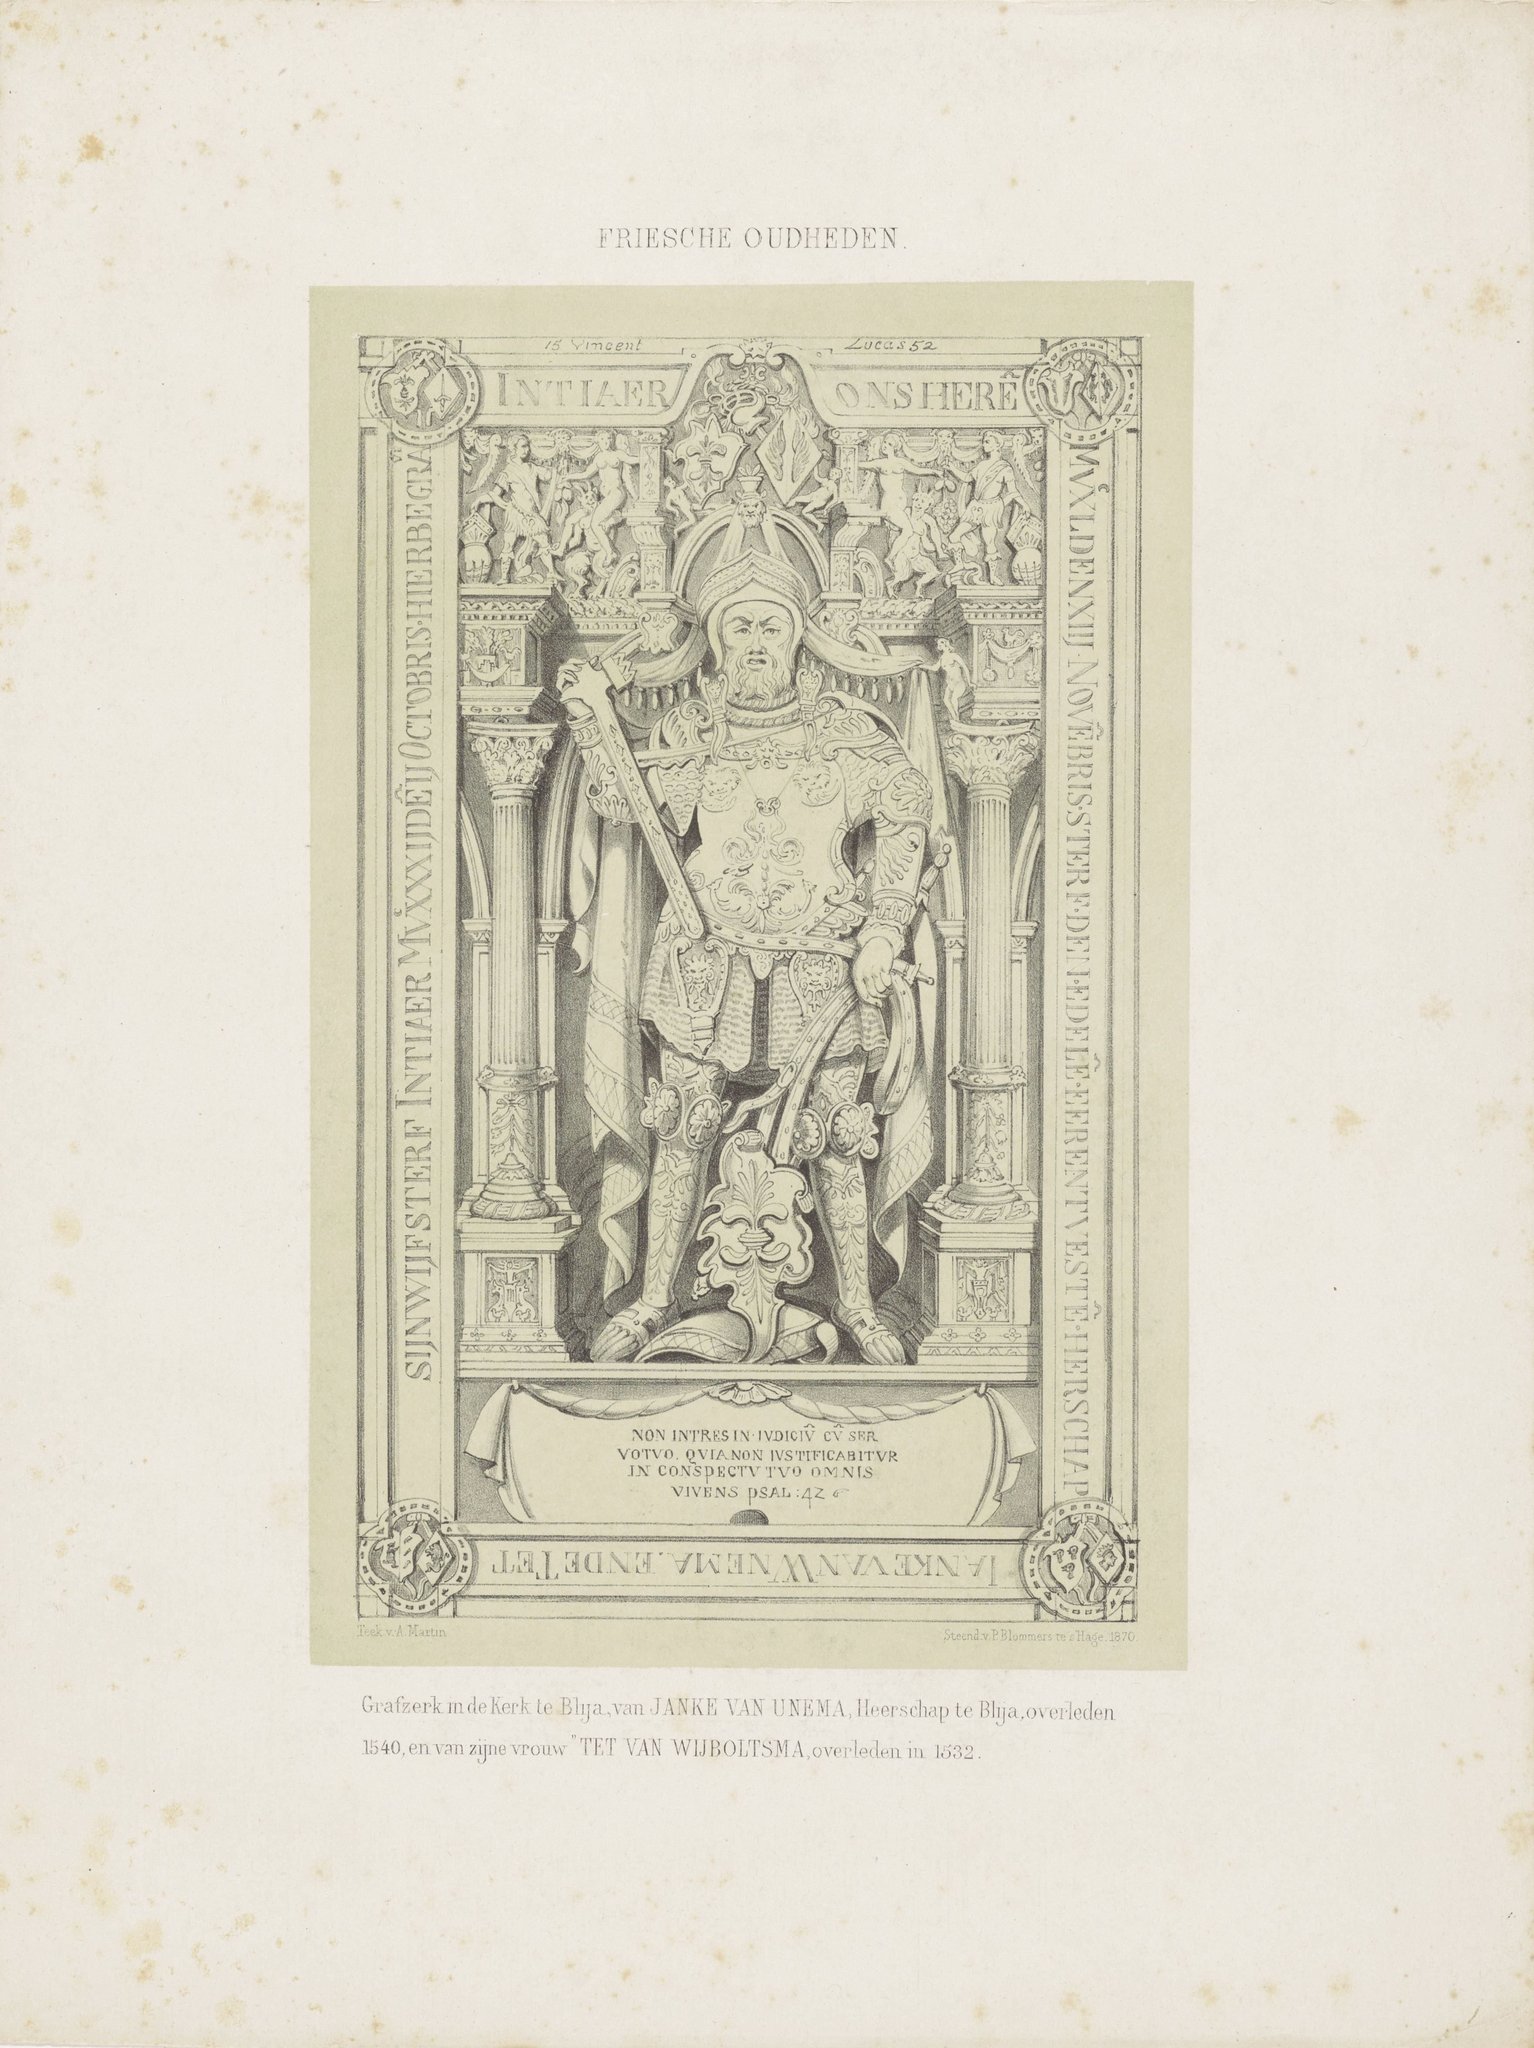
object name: print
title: Grafzerk in de kerk van Blija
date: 1871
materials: paper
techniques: lithograph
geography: the hague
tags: knight, flat, horizontal gravestone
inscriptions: collector's mark: Lugt 2228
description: Prent uit: S.n. Friesche oudheden. Afbeeldingen van merkwaardige voorwerpen van wetenschap en kunst gevonden in de archieven, kerken, kasteelen, terpen enz. van Friesland. Leeuwarden: Kuipers, H., 1875.